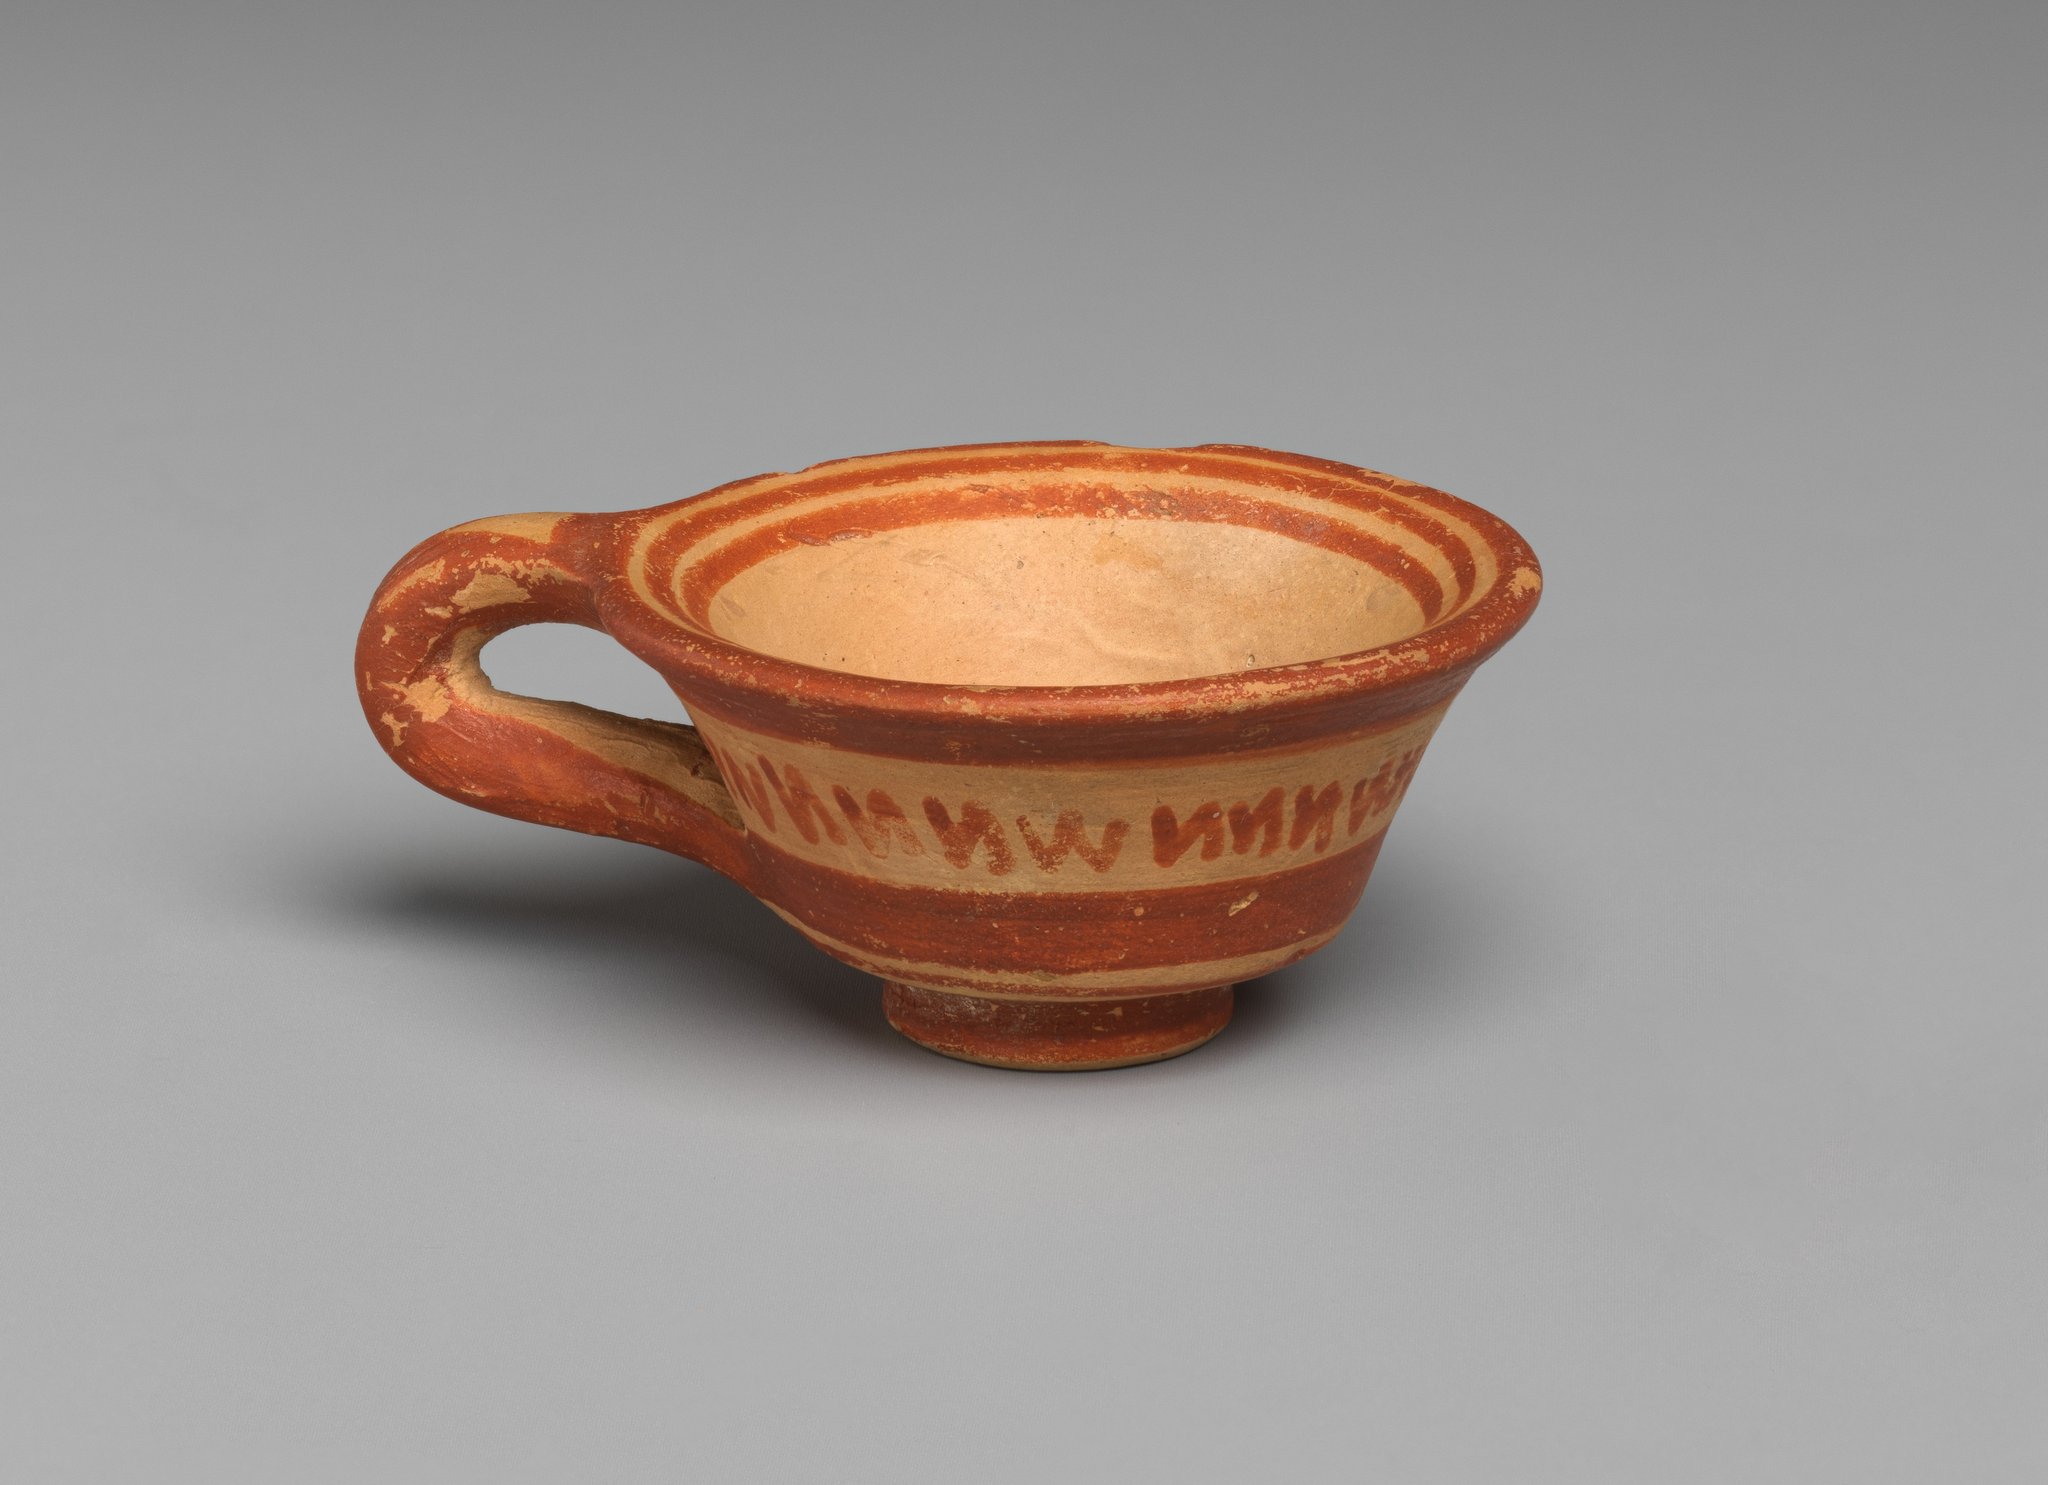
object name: cup, one handled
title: Terracotta one-handled cup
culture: helladic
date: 1300-1200 BCE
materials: terracotta